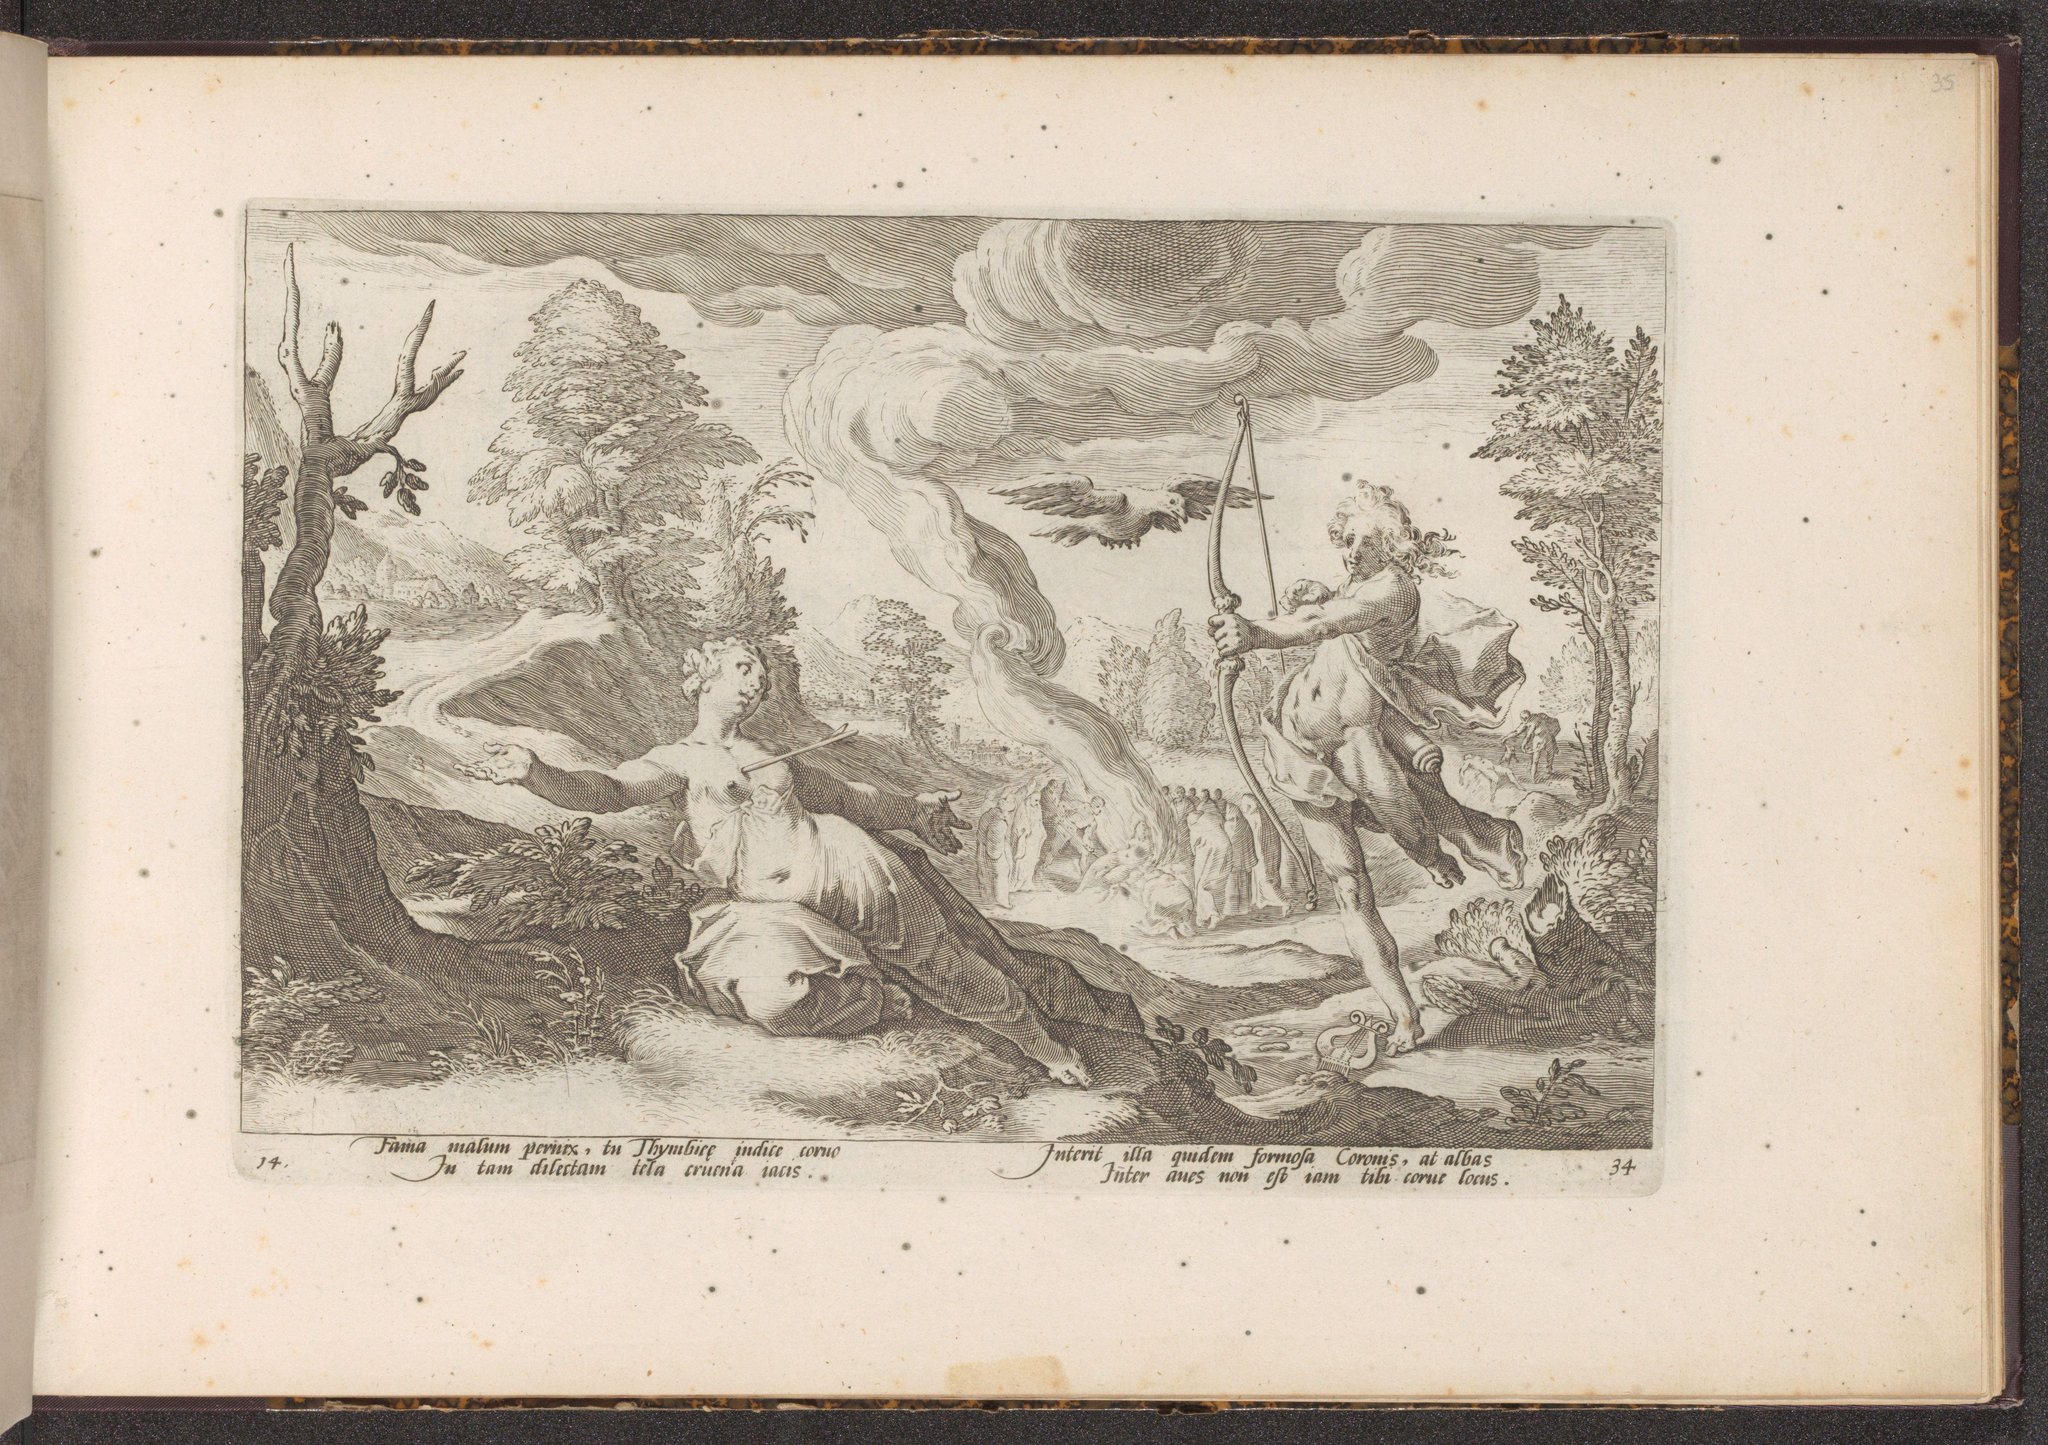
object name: album leaf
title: Apollo doodt Coronis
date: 1590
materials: paper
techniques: engraving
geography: haarlem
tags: apollo (or mercury) cuts the still living aesculapius from coronis' womb, apollo shoots coronis, but repenting his act he tries in vain to recall her to life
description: Ondanks de waarschuwing van de kraai Cornix vertelt de witte raaf Corvus Apollo van het overspel van zijn geliefde Coronis. Sindsdien zijn alle raven zwart. De god schiet de zwangere Coronis met pijl en boog dood. Voordat haar lichaam werd gecremeerd, haalt Apollo het kind Asclepius uit haar buik. Onder de voorstelling twee keer twee versregels in het Latijn. De prent maakt deel uit van een album.